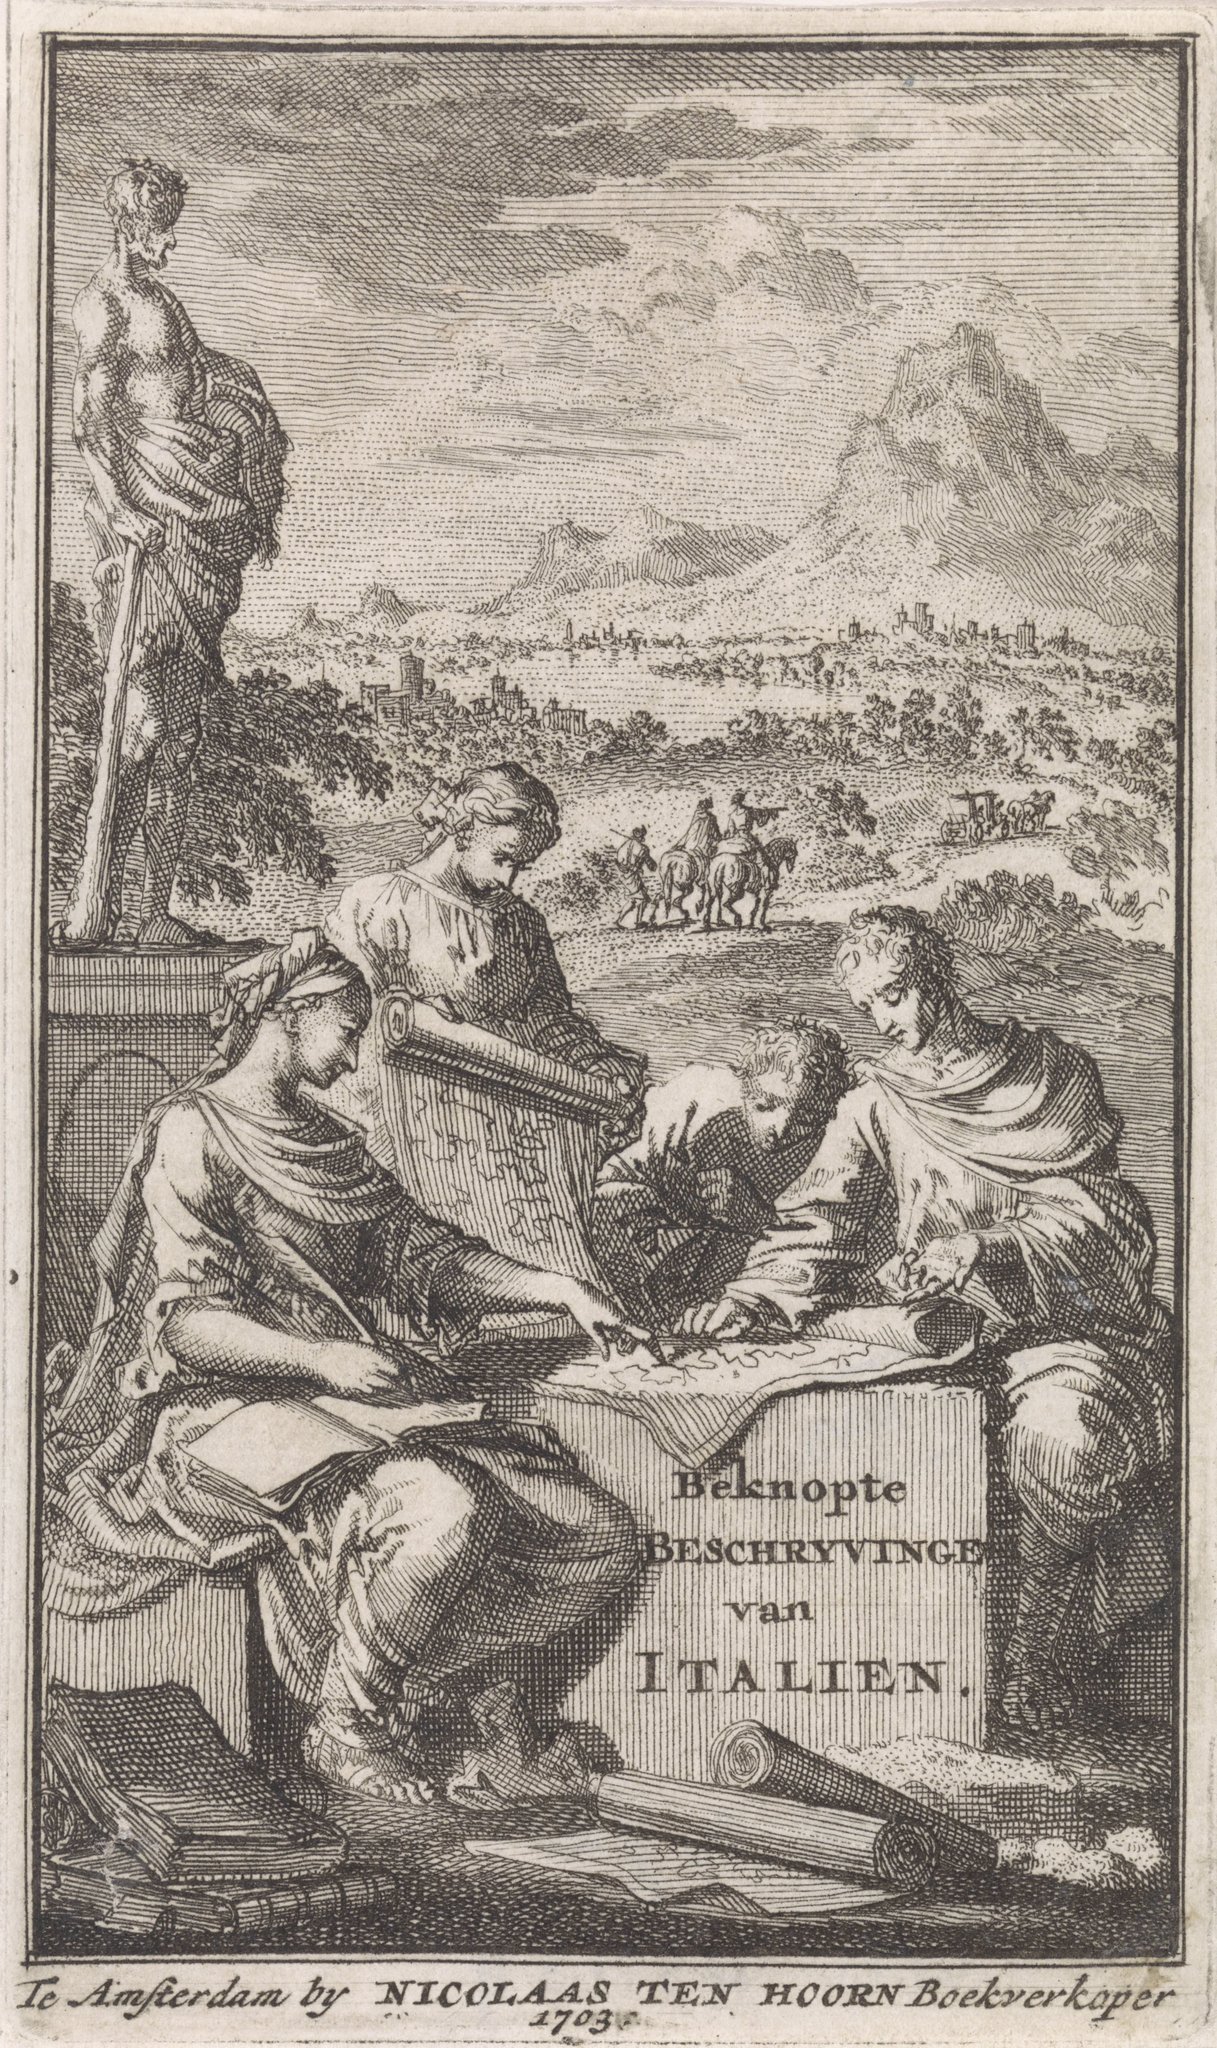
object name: titelblad, titelpagina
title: Titelpagina voor: Beknopte beschryving van Italien, 1703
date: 1703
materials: paper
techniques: etching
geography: amsterdam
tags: (story of) hercules (heracles), studying a map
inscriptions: collector's mark: Lugt 2228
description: Titelpagina voor: Beknopte beschryving van Italien. Amsterdam: Nicolaas ten Hoorn, 1703.